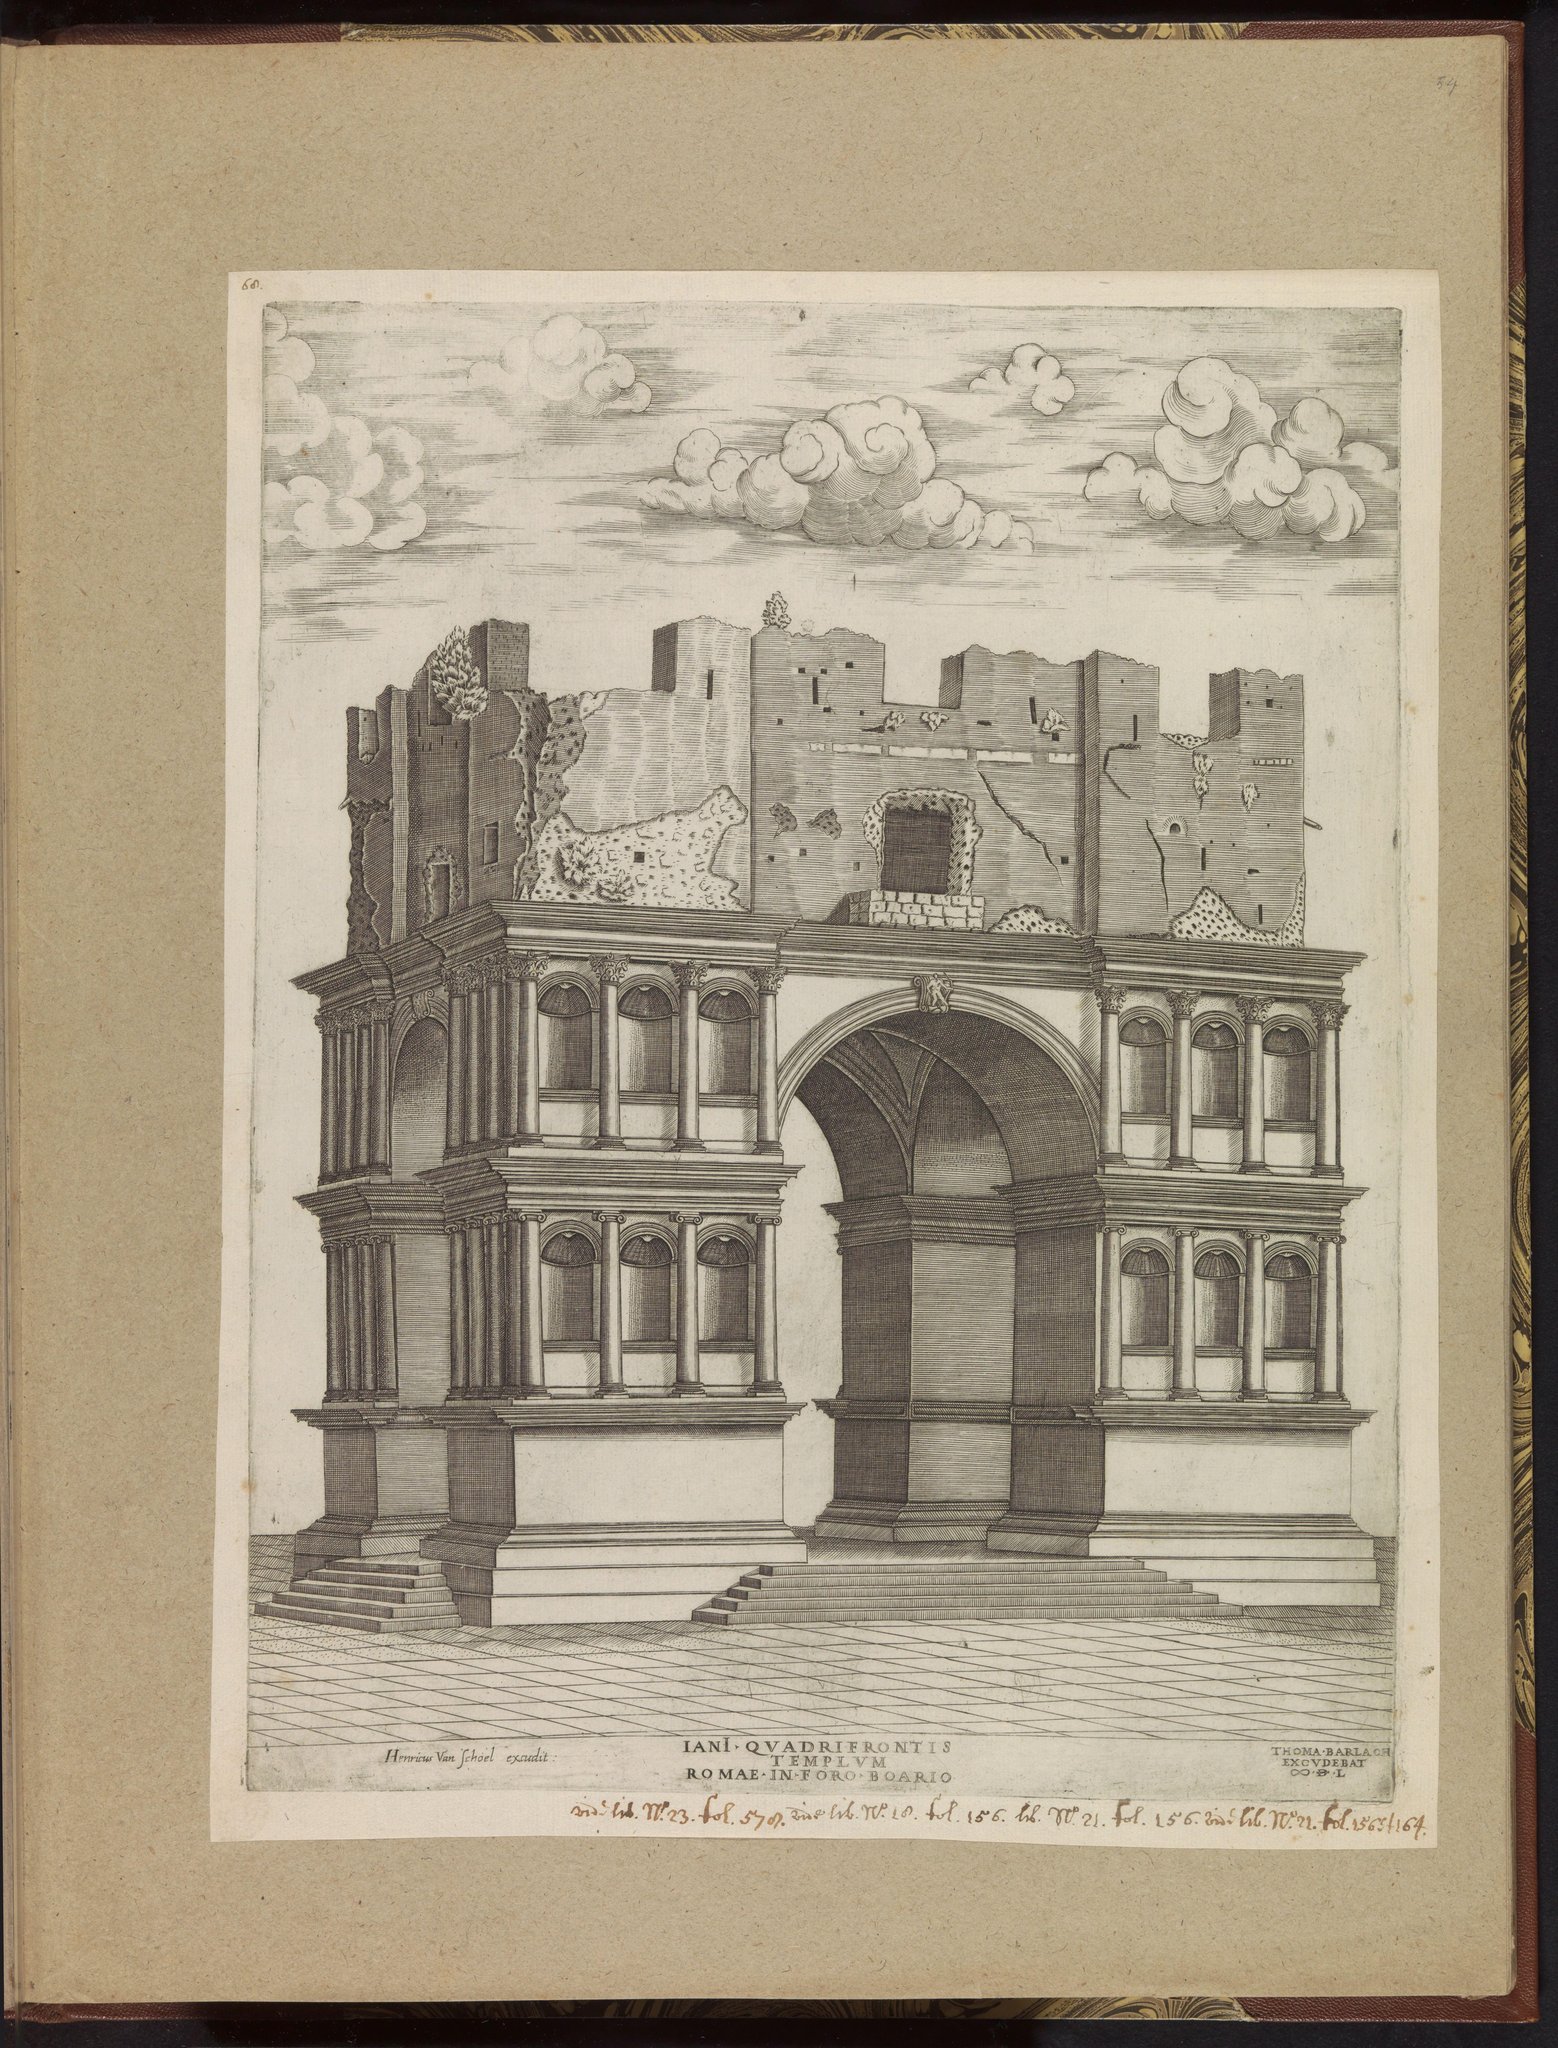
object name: print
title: Iani Quadrifrontis Templum Romae in Foro Boario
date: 1550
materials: paper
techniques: engraving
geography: italy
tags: triumphal arch, representation of real building (either existing or having existed)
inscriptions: number: ‘68’, inscription: ‘Ende lib. No. 23. fol. 578. Ende lib. No. 18. fol. 156. lib. No. 21. fol. 156. Ende lib. No. 22. fol. 156, 164.’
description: Deze prent behoort tot het prentcorpus dat bekend staat als de ‘Speculum Romanae Magnificentiae’ (‘Spiegel van Romeinse pracht’). Dit corpus, bestaande uit prenten met voorstellingen van kunstwerken en gebouwen uit het antieke en het moderne Rome, vond zijn oorsprong bij uitgevers Antonio Salamanca en Antonio Lafreri. Deze twee buitenlandse uitgevers bundelden hun krachten te Rome in de periode 1553-1563. Hun prenten werden al snel razend populair bij toeristen en verzamelaars, die de prenten individueel of in grote groepen aanschaften. Grote groepen Speculum-prenten werden vaak op aanvraag samengebonden in albums. Er zijn verschillende Speculum-albums overgeleverd die allemaal verschillen van inhoud. Tussen 1573 en 1577 gaf Antonio Lafreri een speciale titelpagina uit (met de titel ‘Speculum Romanae Magnificentiae’) die mensen voor hun verzamelingen konden voegen. Het overlijden van Lafreri in 1577 betekende niet het einde van het corpus. Een groot deel van de koperplaten ging over op Claudio en Stefano Duchetti. De rest raakte verspreid over verschillende andere uitgevers. De populariteit van de Speculum-prenten wist nog geruime periode uitgevers te inspireren tot het laten maken van kopieën en het toevoegen van nieuwe prenten aan het corpus.